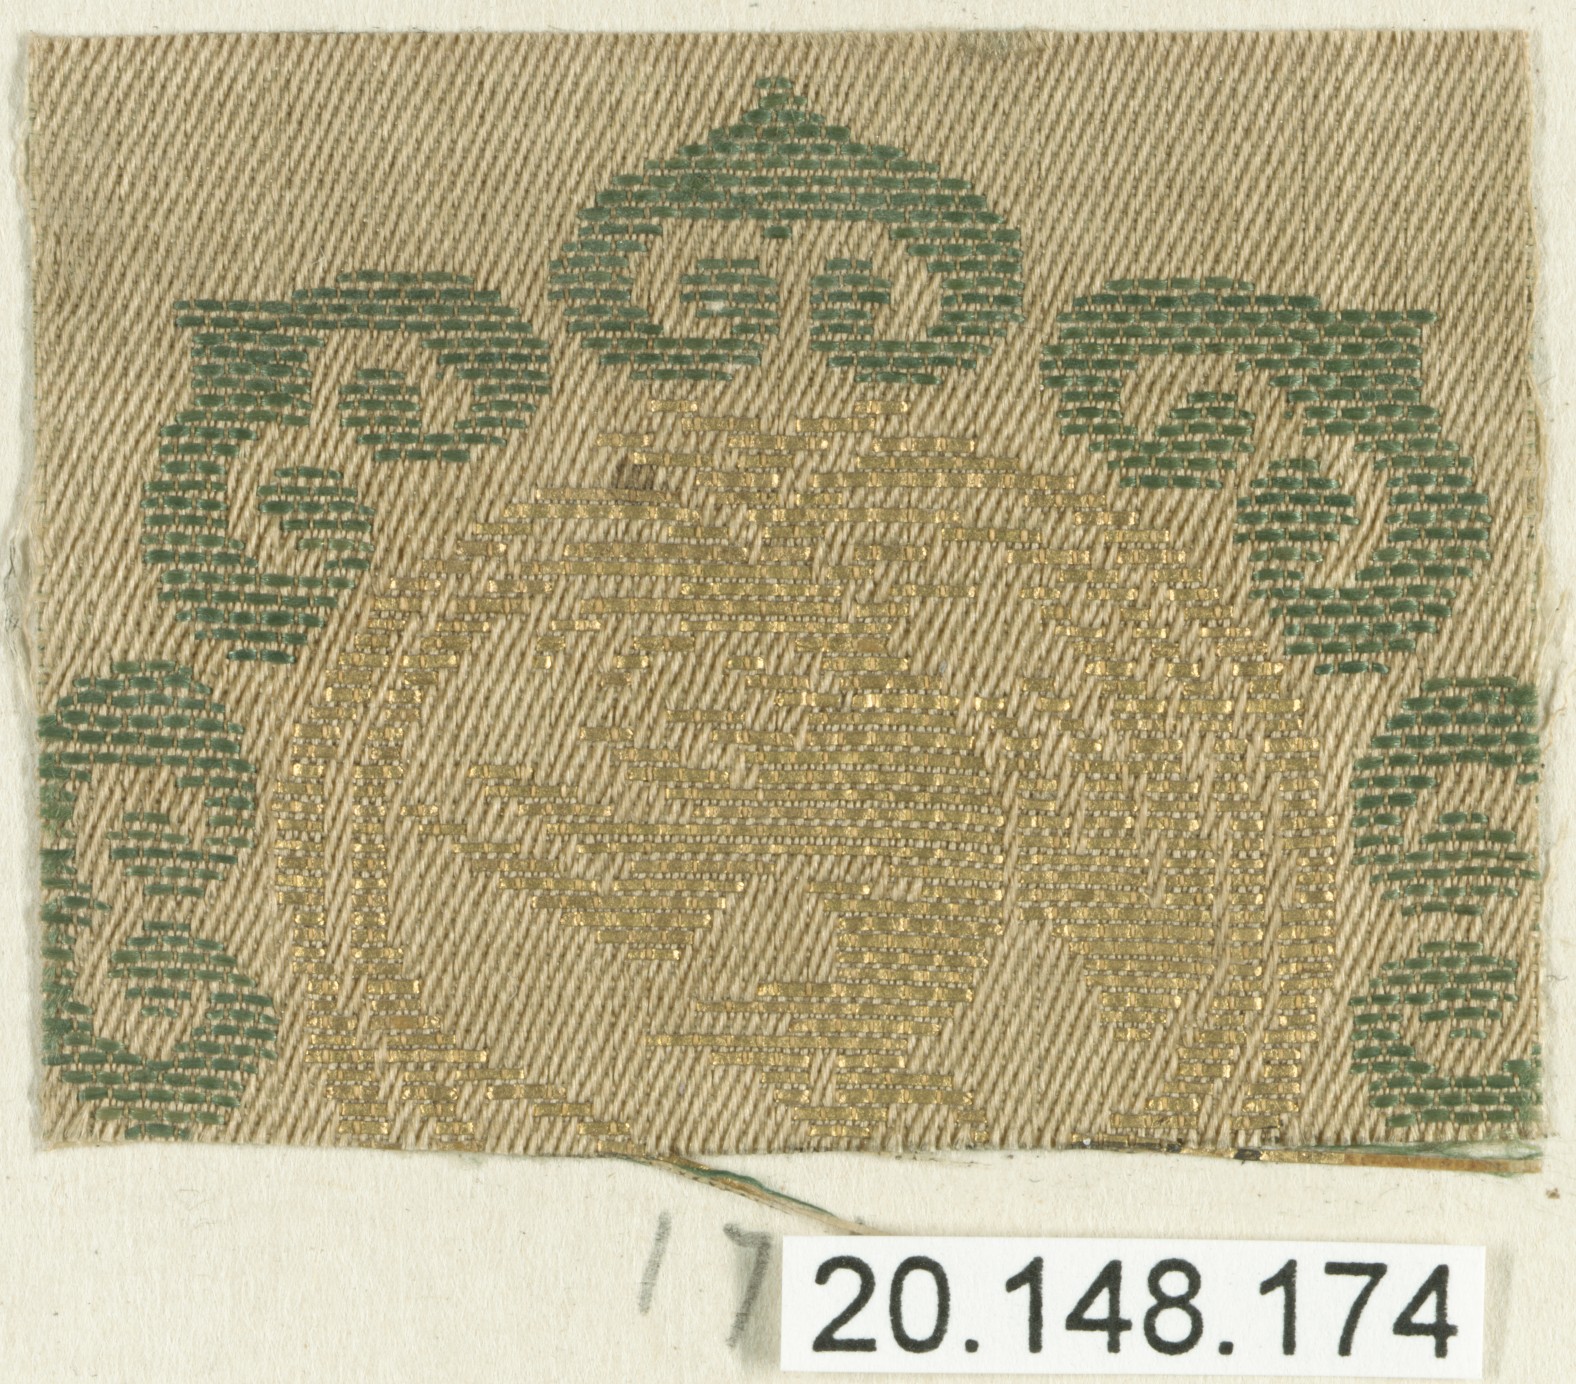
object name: piece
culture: japanese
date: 1701-1800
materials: silk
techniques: compound weave